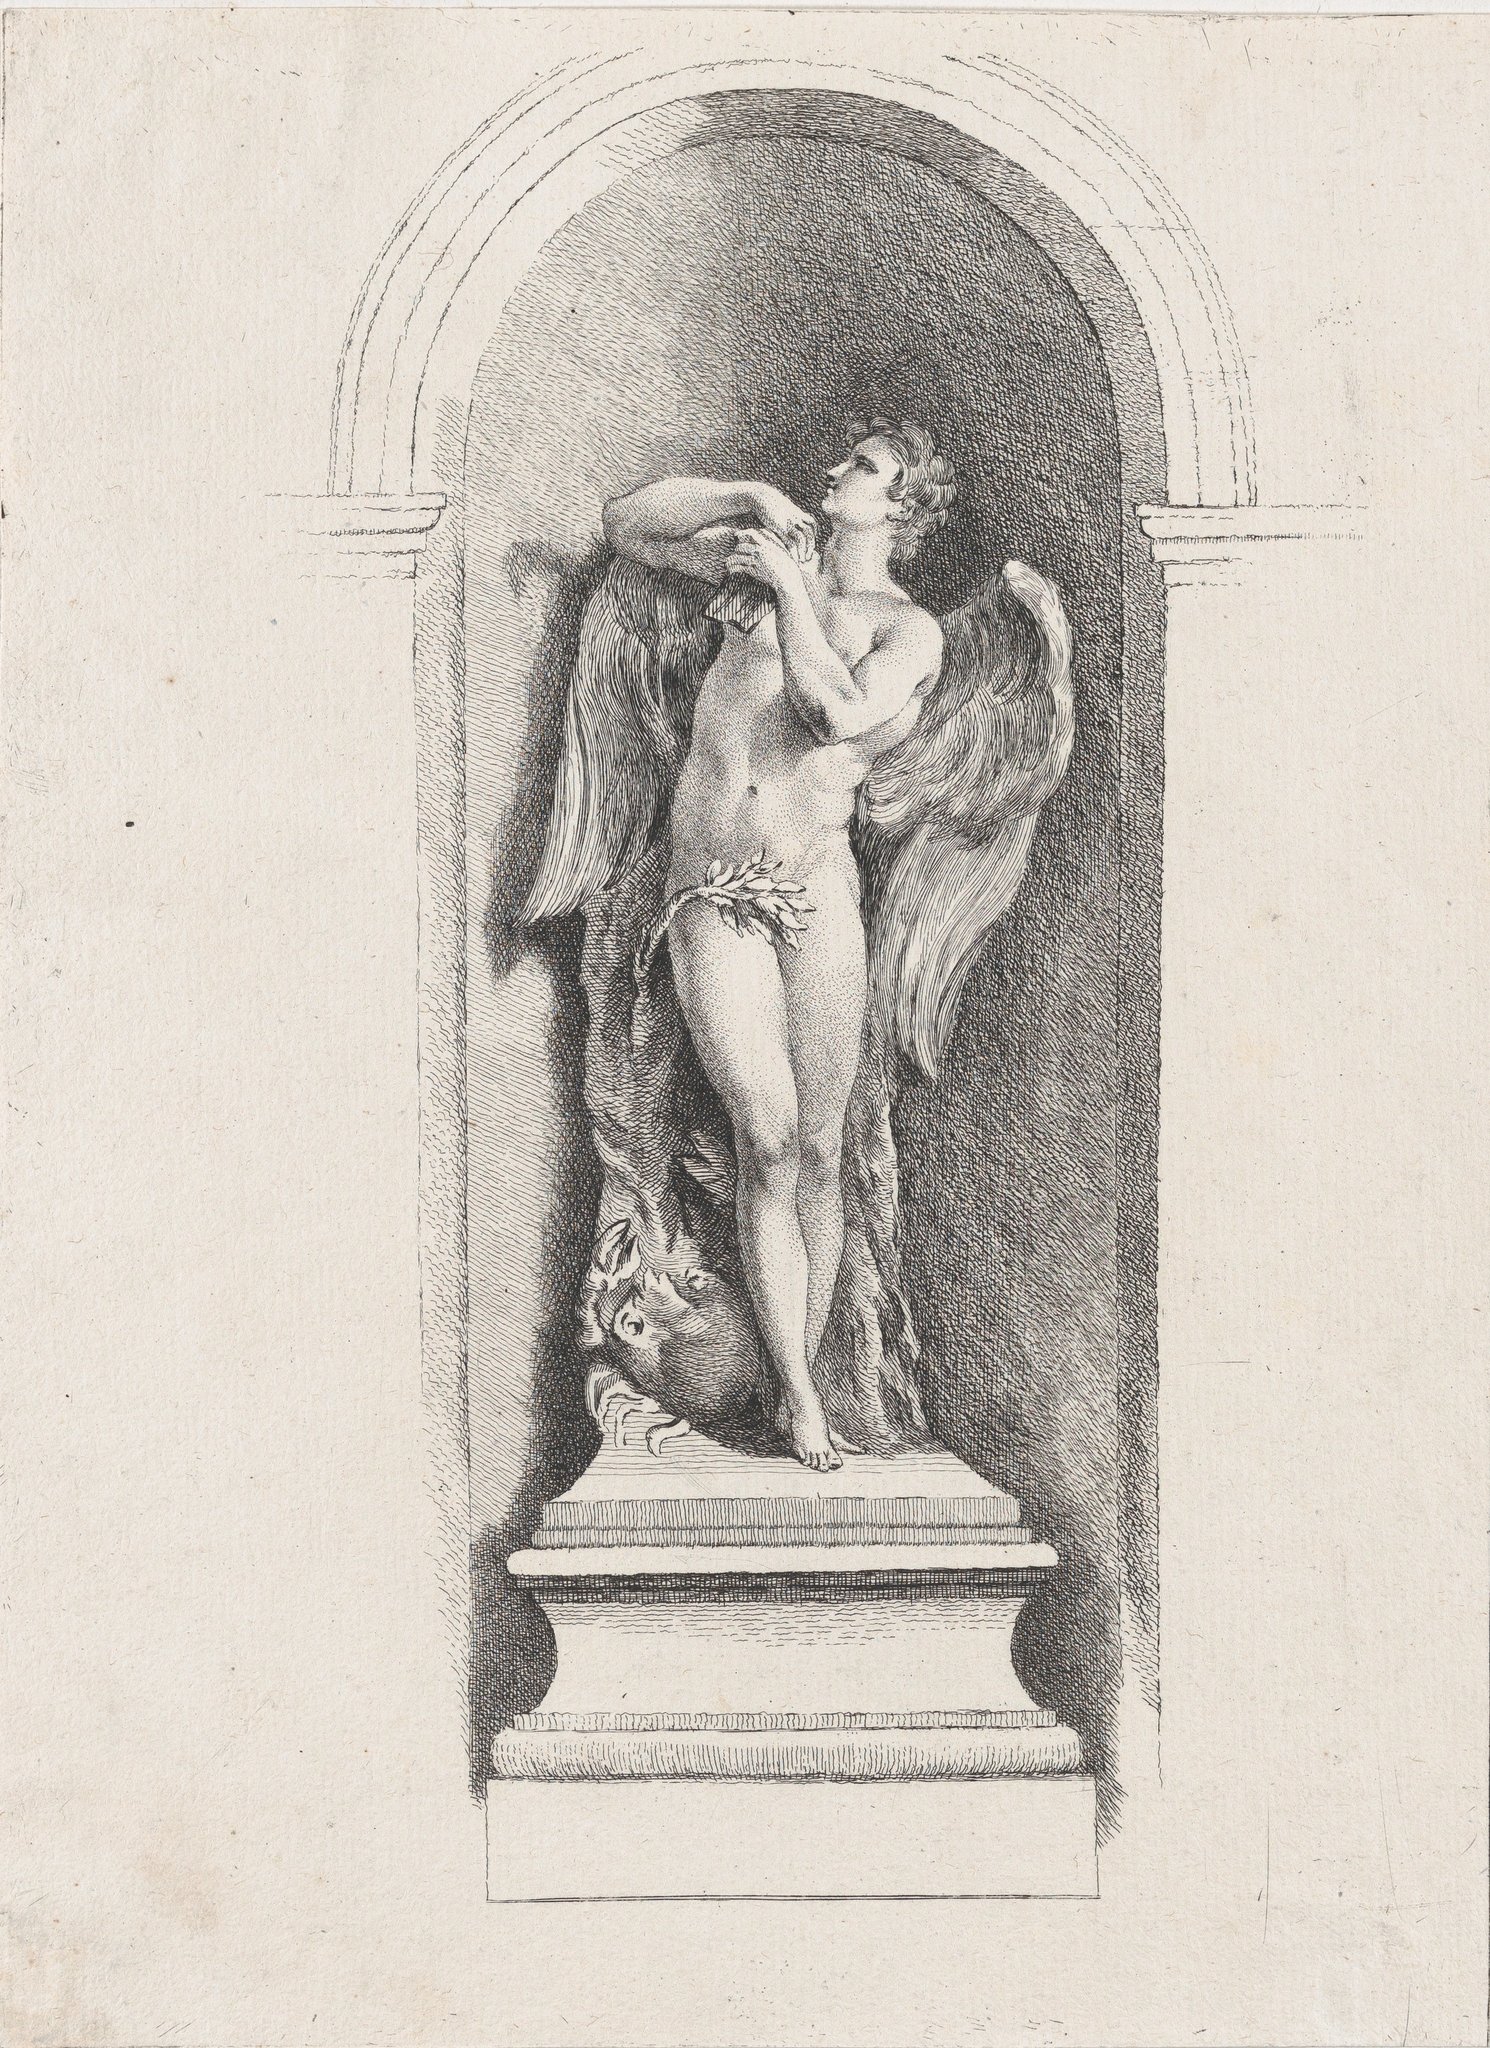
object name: print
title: Standing male angel looking up and holding a flute; after Fontaine des Quatre-Saisons (Paris)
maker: anonymous, french, 18th century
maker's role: artist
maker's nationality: french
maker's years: 1700-1800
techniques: etching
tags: angels